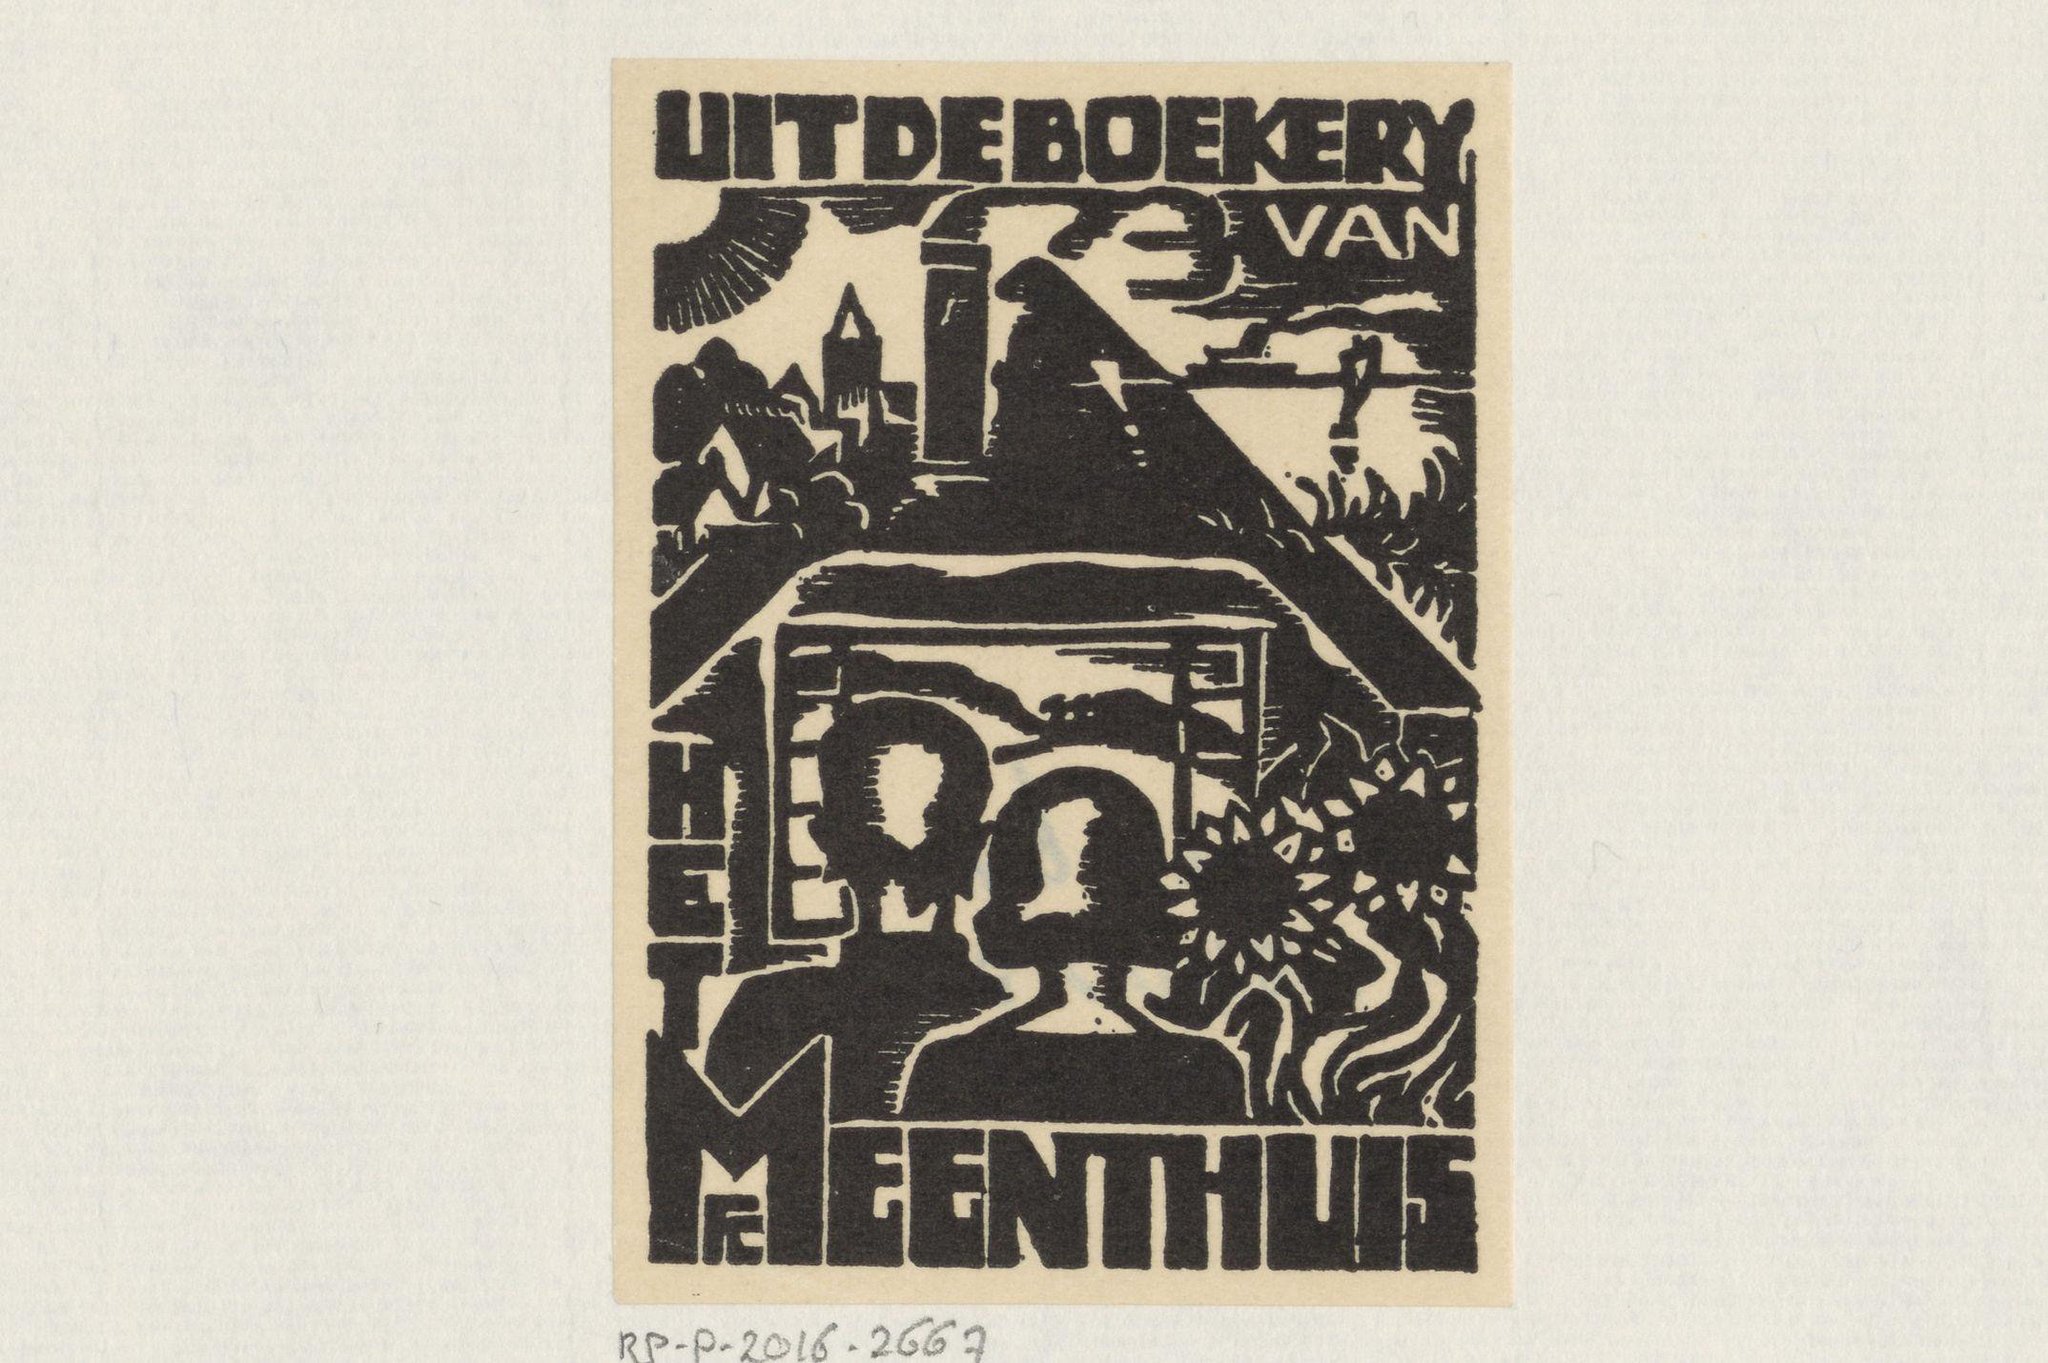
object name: bookplate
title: Ex libris van het Meenthuis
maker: fré cohen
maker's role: draughtsman, print maker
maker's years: 1903-1943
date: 1932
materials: paper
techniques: woodcut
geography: netherlands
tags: head (human), village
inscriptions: signature, date and inscription: ‘Holzschnitt / Fré Cohen / 1932’